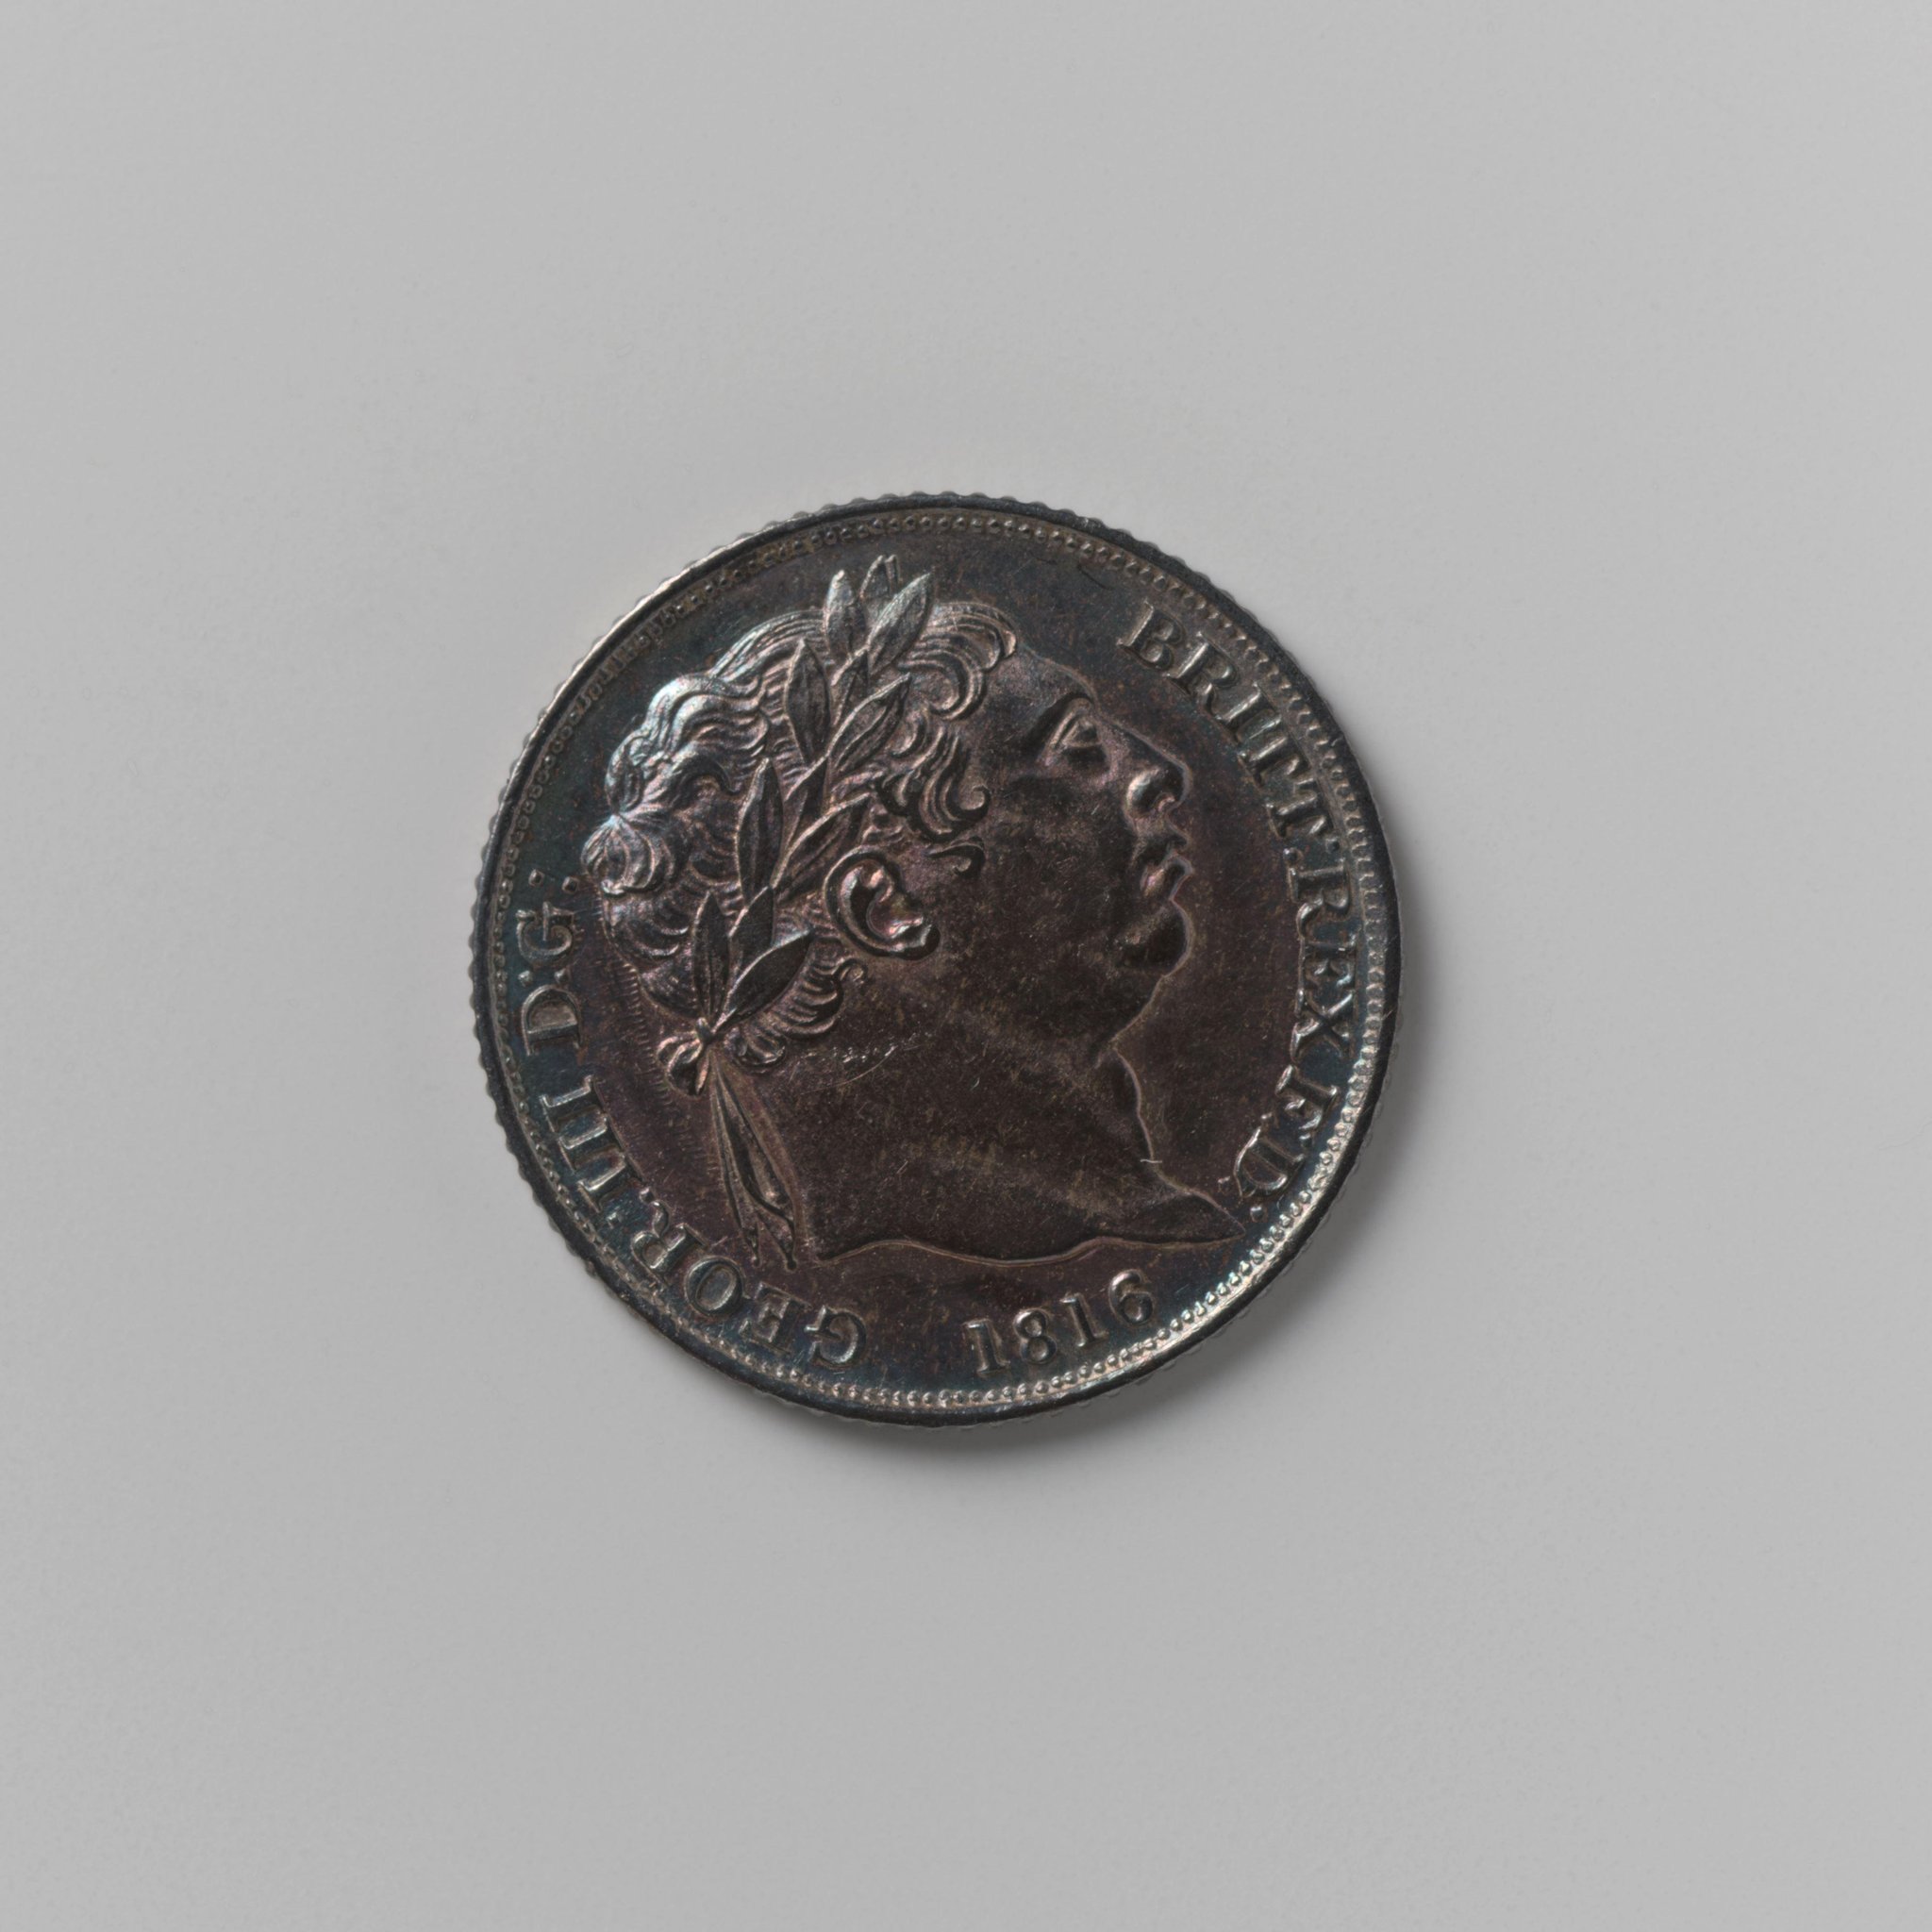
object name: coin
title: 6 pence uit Engeland van George III, 1816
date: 1816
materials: silver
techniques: striking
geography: london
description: Zilveren munt. Voorzijde: gelauwerd hoofd van de koning naar rechts. Jaartal in omschrift onderaan. Keerzijde: door de band van de Orde van de Kousenband, waaraan juweel, omhangen gekrooond wapenschild. Kartelrand.